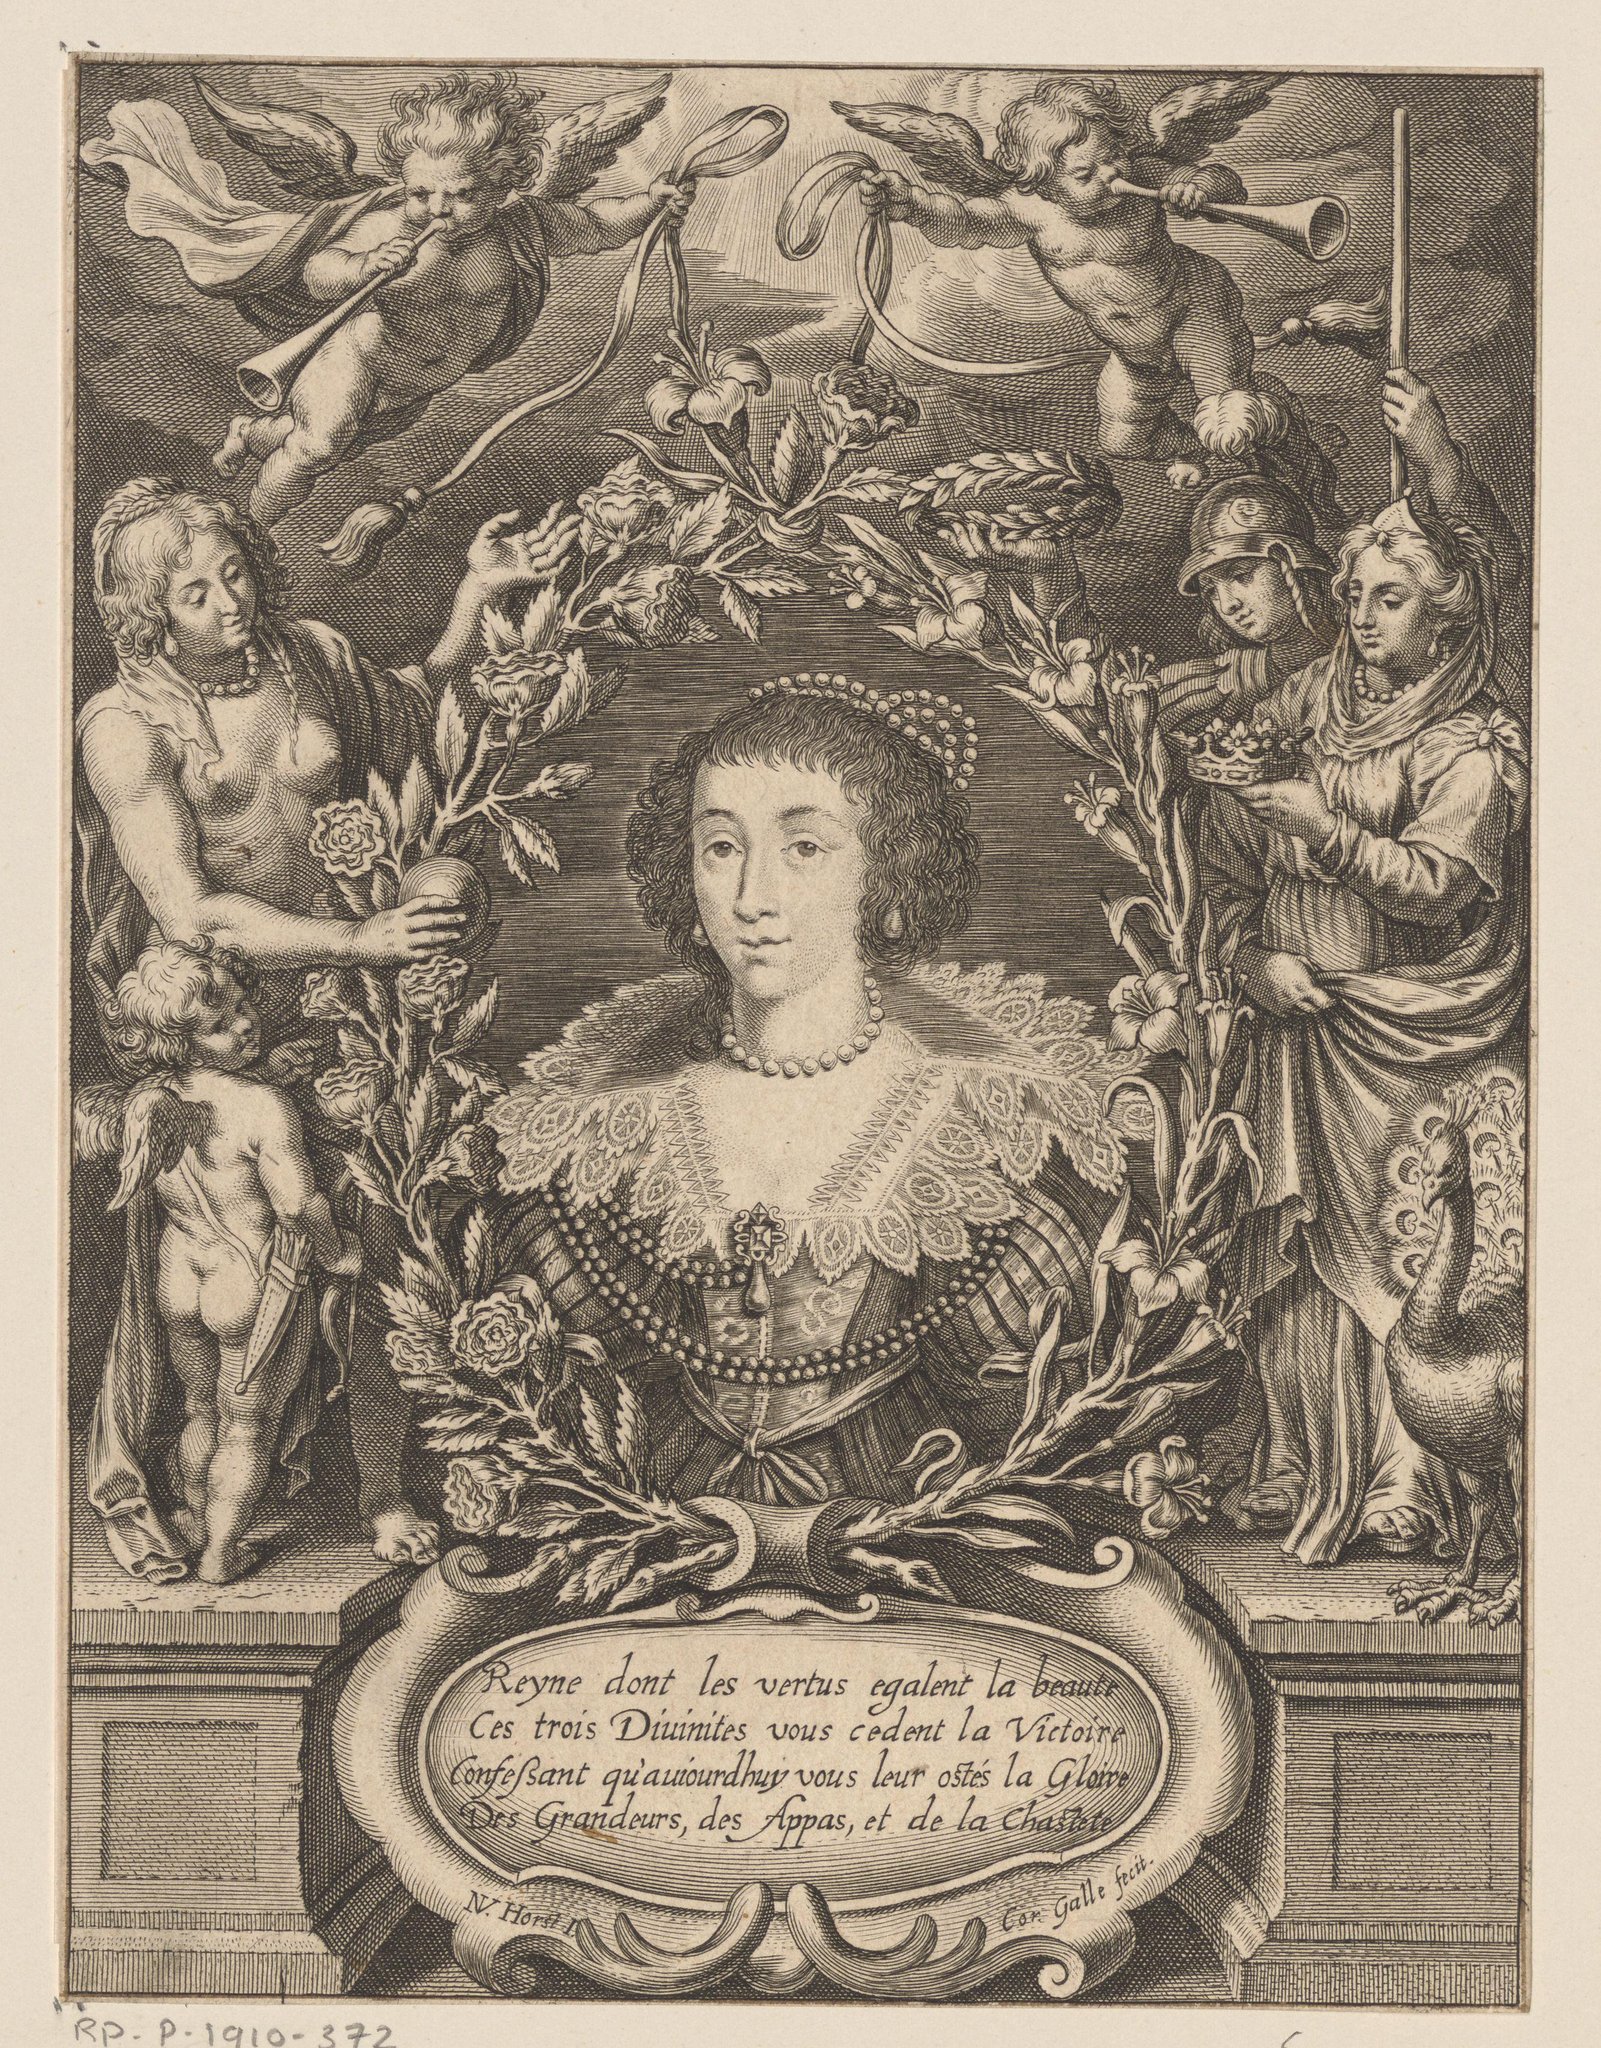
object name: print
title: Portret van Henriëtta Maria van Frankrijk, koningin van Engeland, Schotland en Ierland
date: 1625-1678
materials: paper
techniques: engraving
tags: henriëtta maria van frankrijk (koningin van engeland, schotland en ierland), (story of) juno (hera), (story of) minerva (pallas, athena), historical persons - bb - woman, queen, (personifications and symbolic representations of) love; 'amore (secondo seneca)' (ripa), ornamental birds: peacock, (story of) venus (aphrodite)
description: Portret geflankeerd door Amor, Juno, Minerva en Venus.